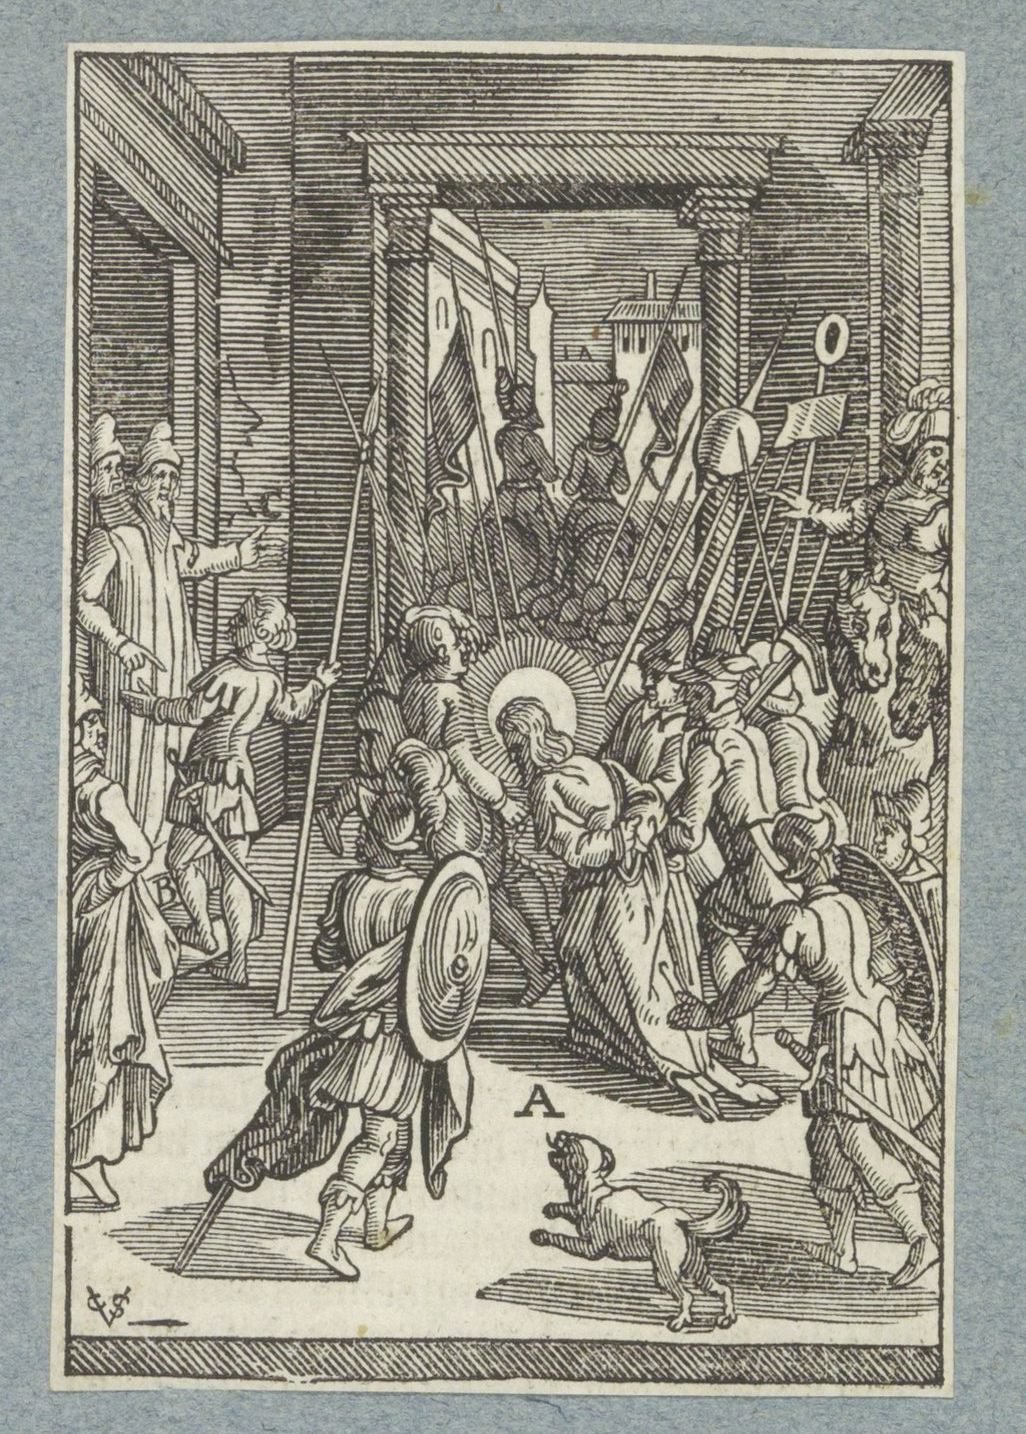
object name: print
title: Christus naar Annas gebracht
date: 1629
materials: paper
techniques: letterpress printing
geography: amsterdam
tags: christ before annas (hanna); maybe a soldier about to strike christ (john 18:13, 18:19-24)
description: De prent is afkomstig uit een van de uitgaven van P.J. Paets uit Amsterdam. De prent wordt voor het eerst gebruikt in: Der Zielen Lust-hof. Leuven, I.Jacbosz voor P.J. Paets [= Amsterdam, P.J. Paets], 1629. De voorstelling is gekopieerd naar een prent van Hieronymus Wierix voor: Nadal, Jerónimo. Evangelicae Historiae Imagines. Antwerpen, M. Nutius, 1593.